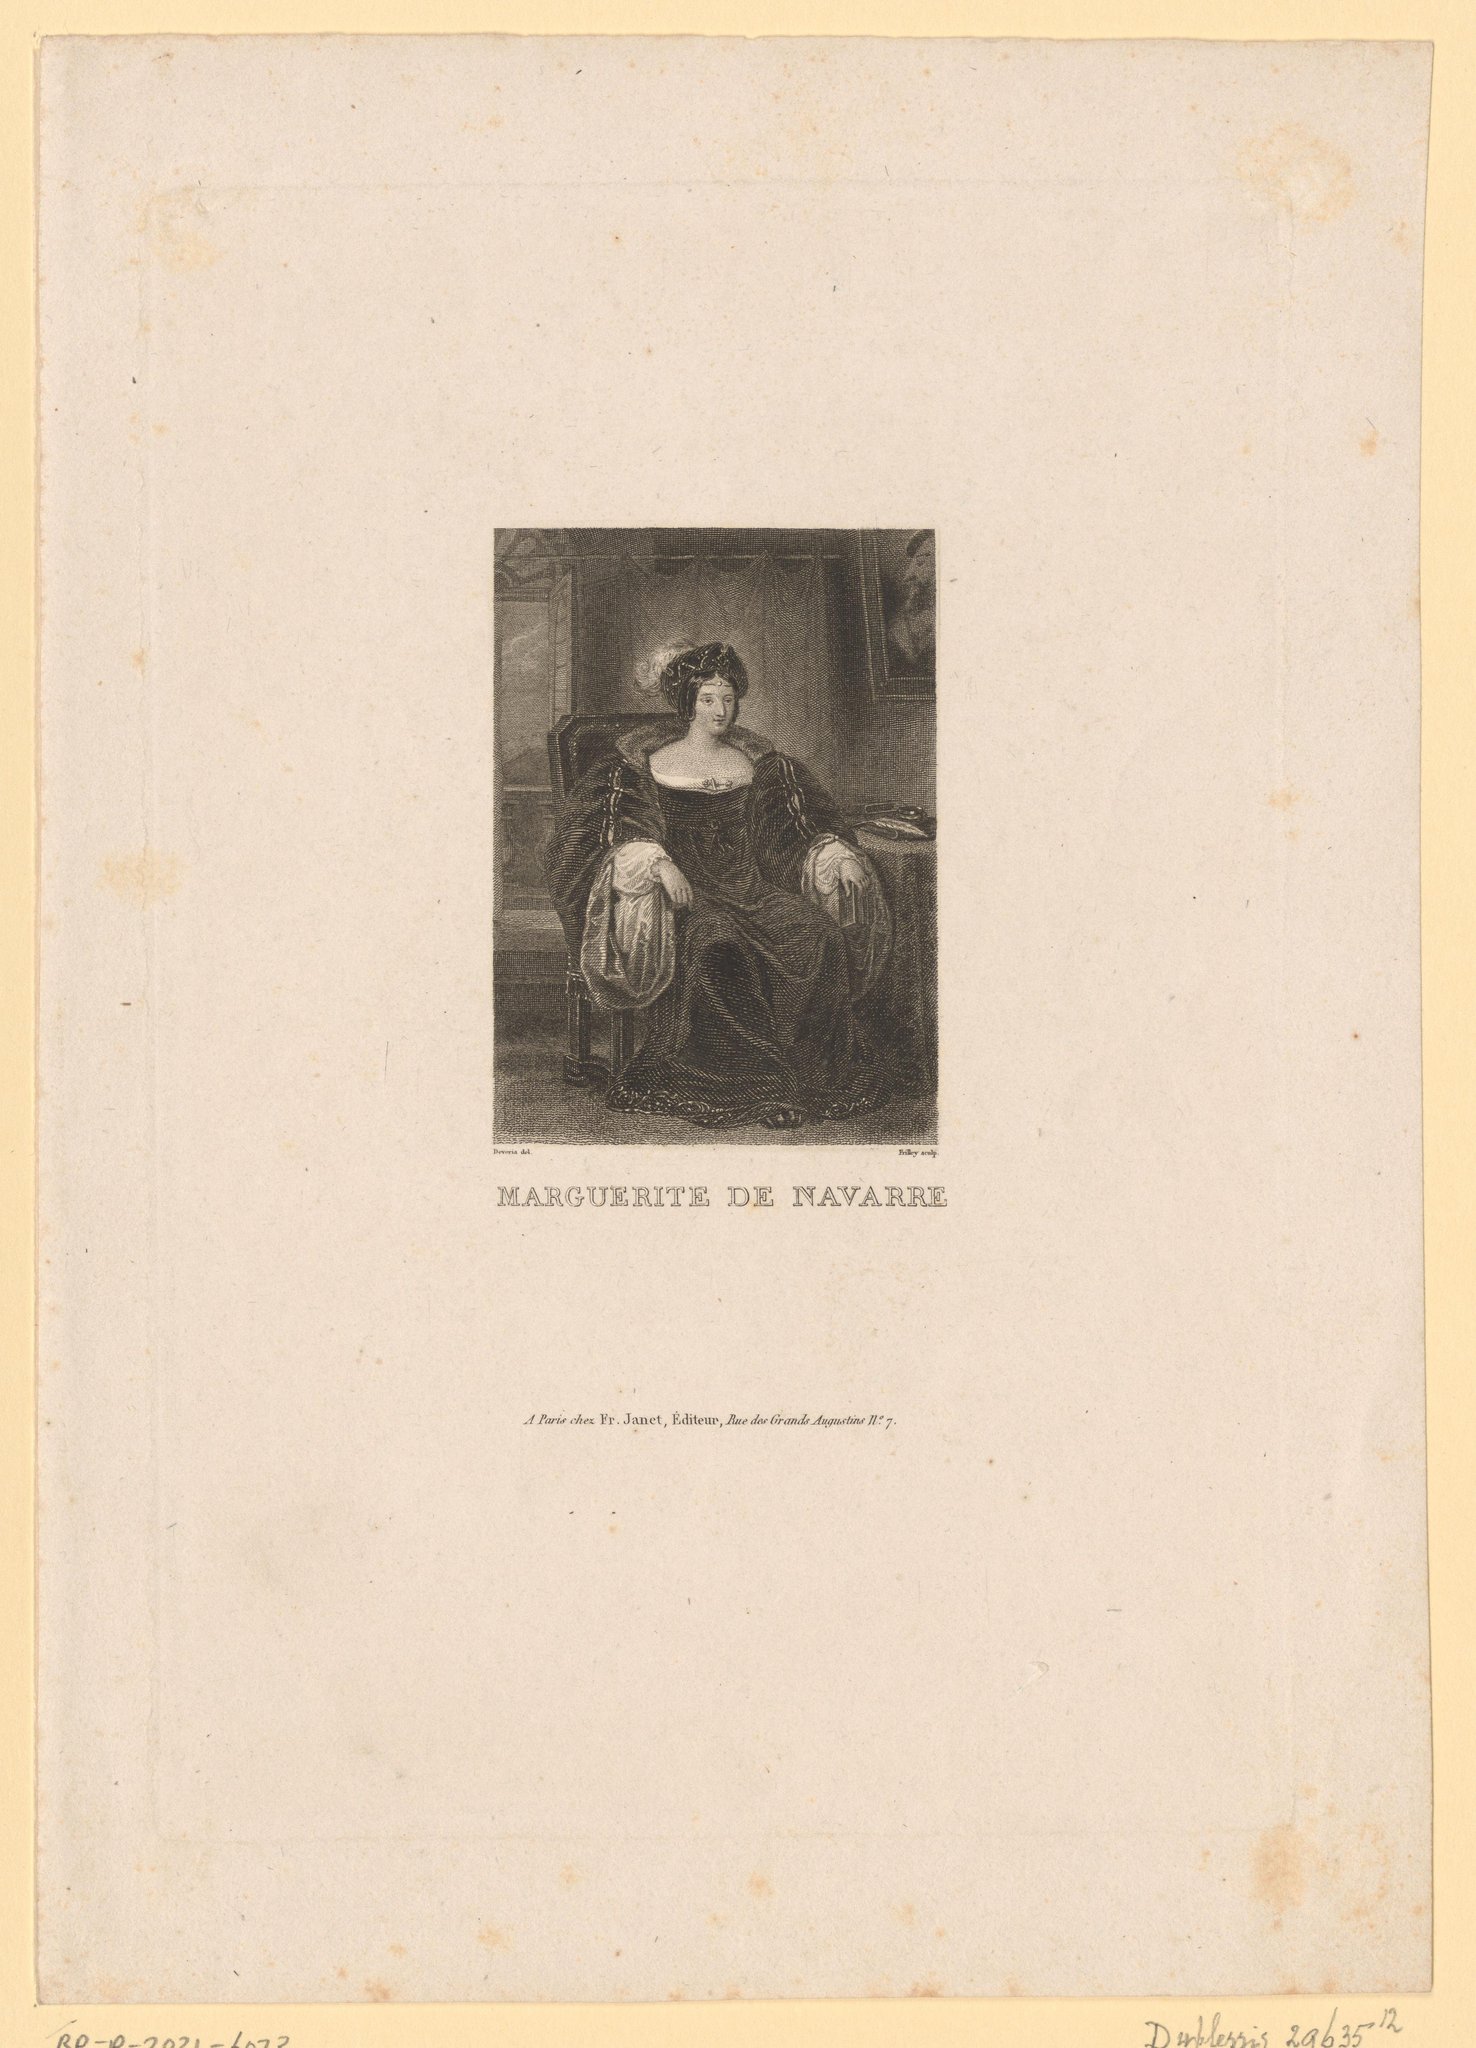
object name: print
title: Marguerite de Navarre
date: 1820-1843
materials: paper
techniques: engraving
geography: paris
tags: historical persons - bb - woman, writing tools